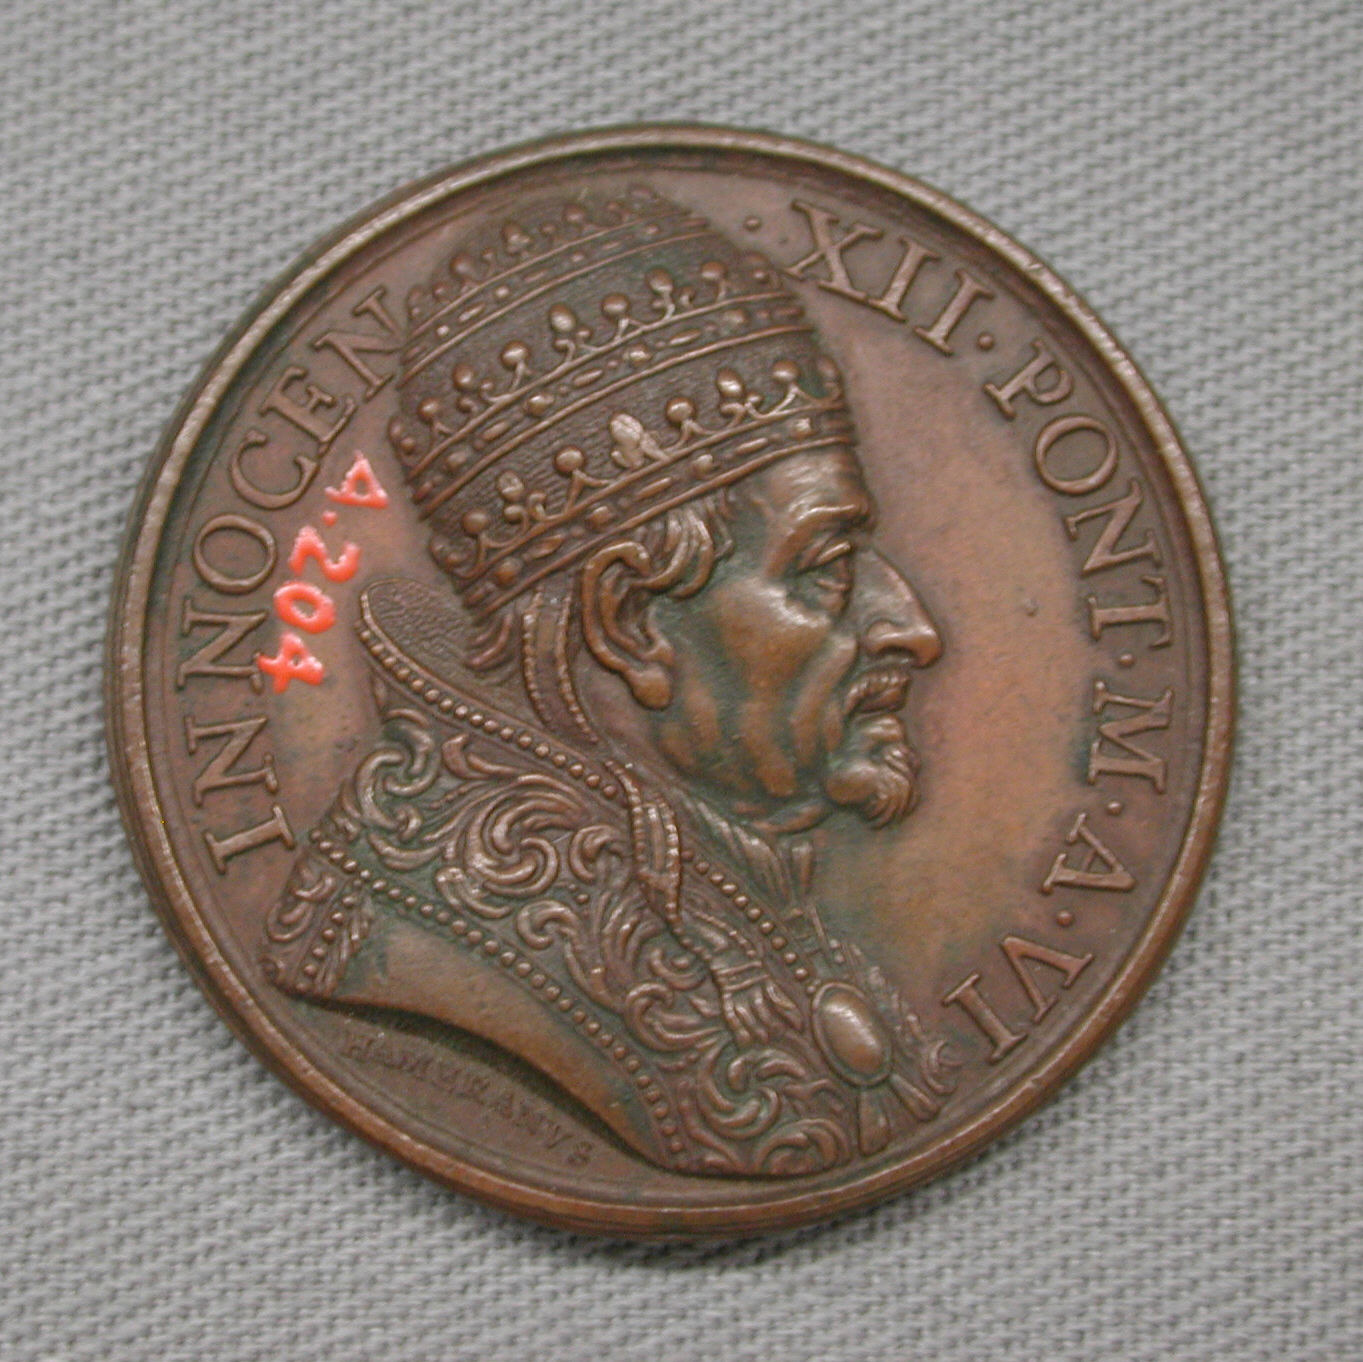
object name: medal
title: Pope Innocent XII (1691–1700)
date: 1601-1700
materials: bronze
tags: men,profiles